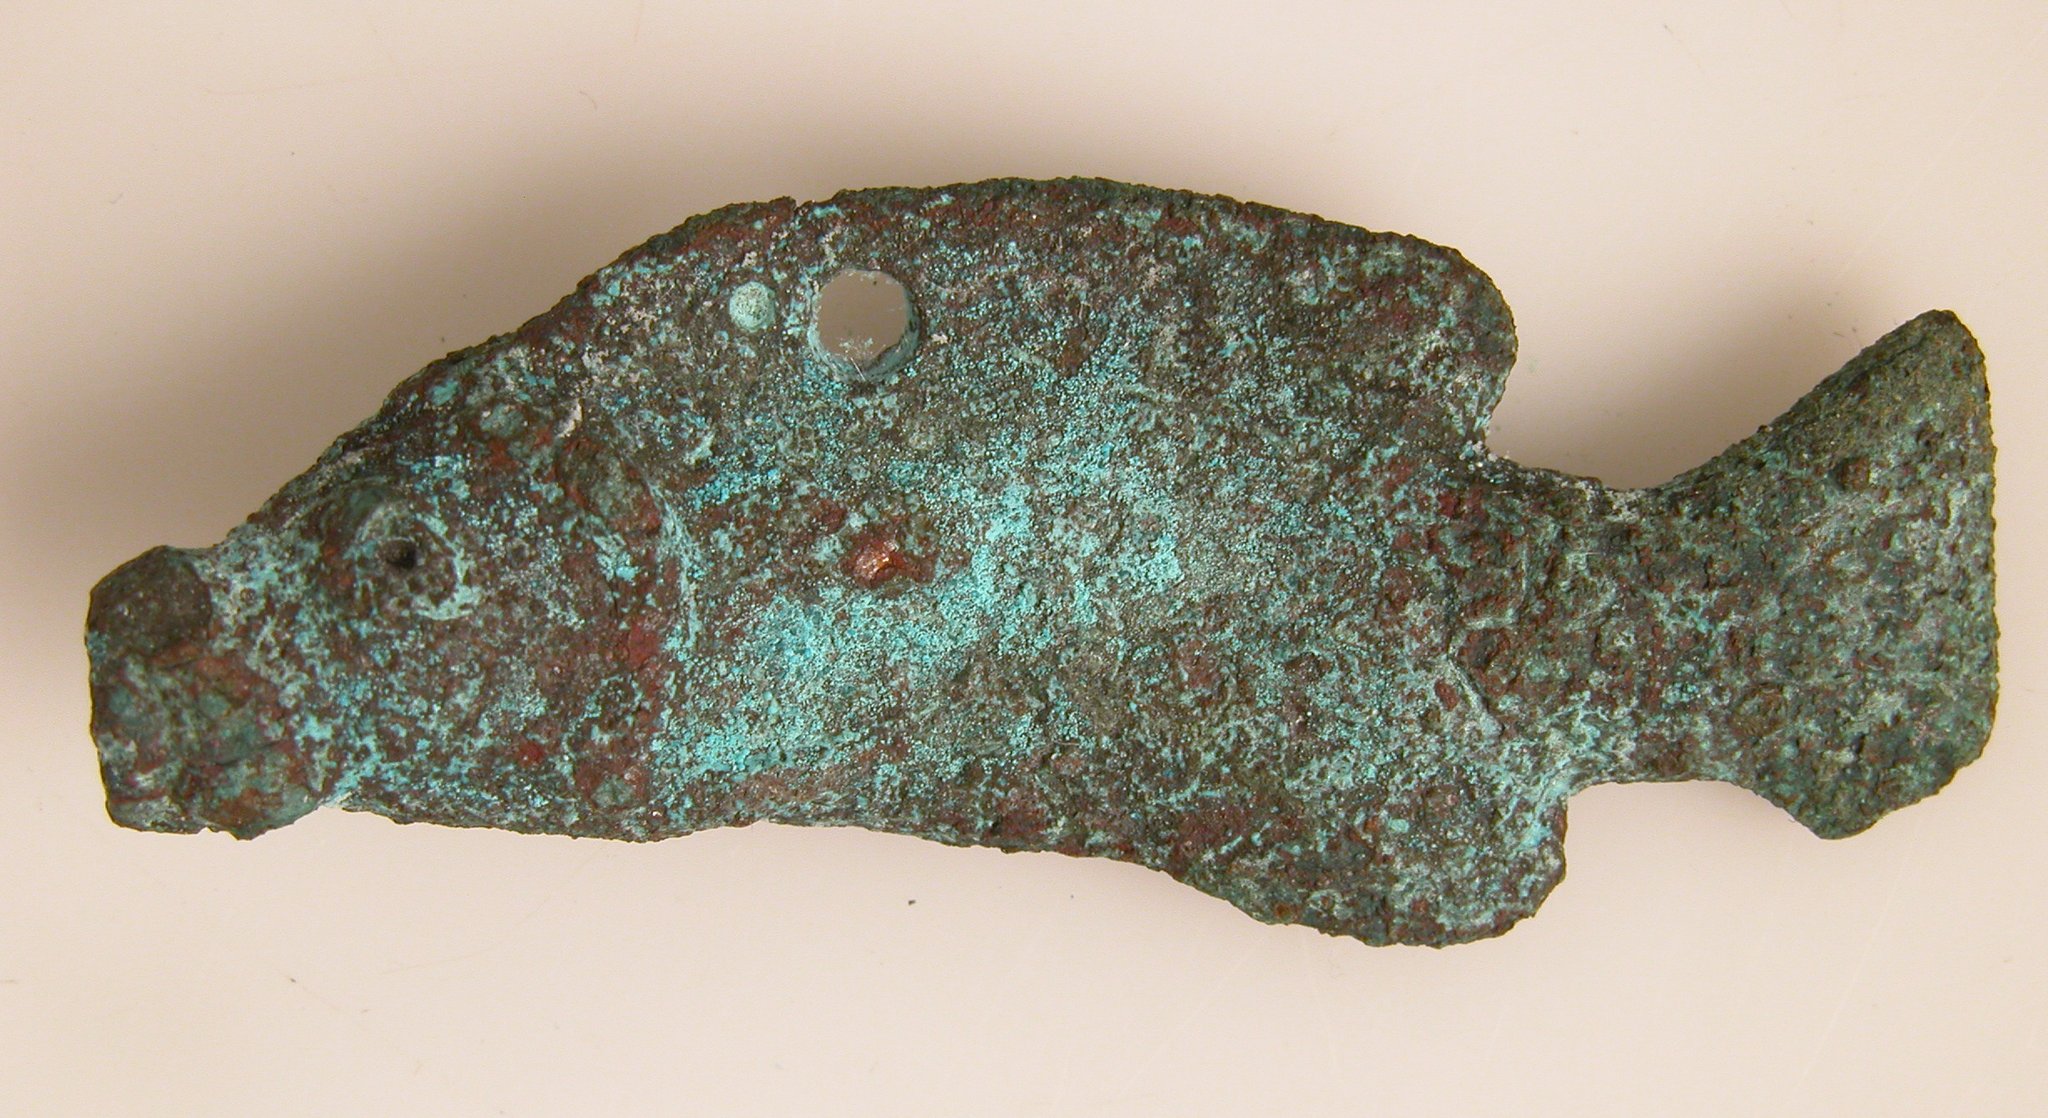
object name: statuette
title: Fish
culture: coptic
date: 301-700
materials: copper alloy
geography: egypt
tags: fish